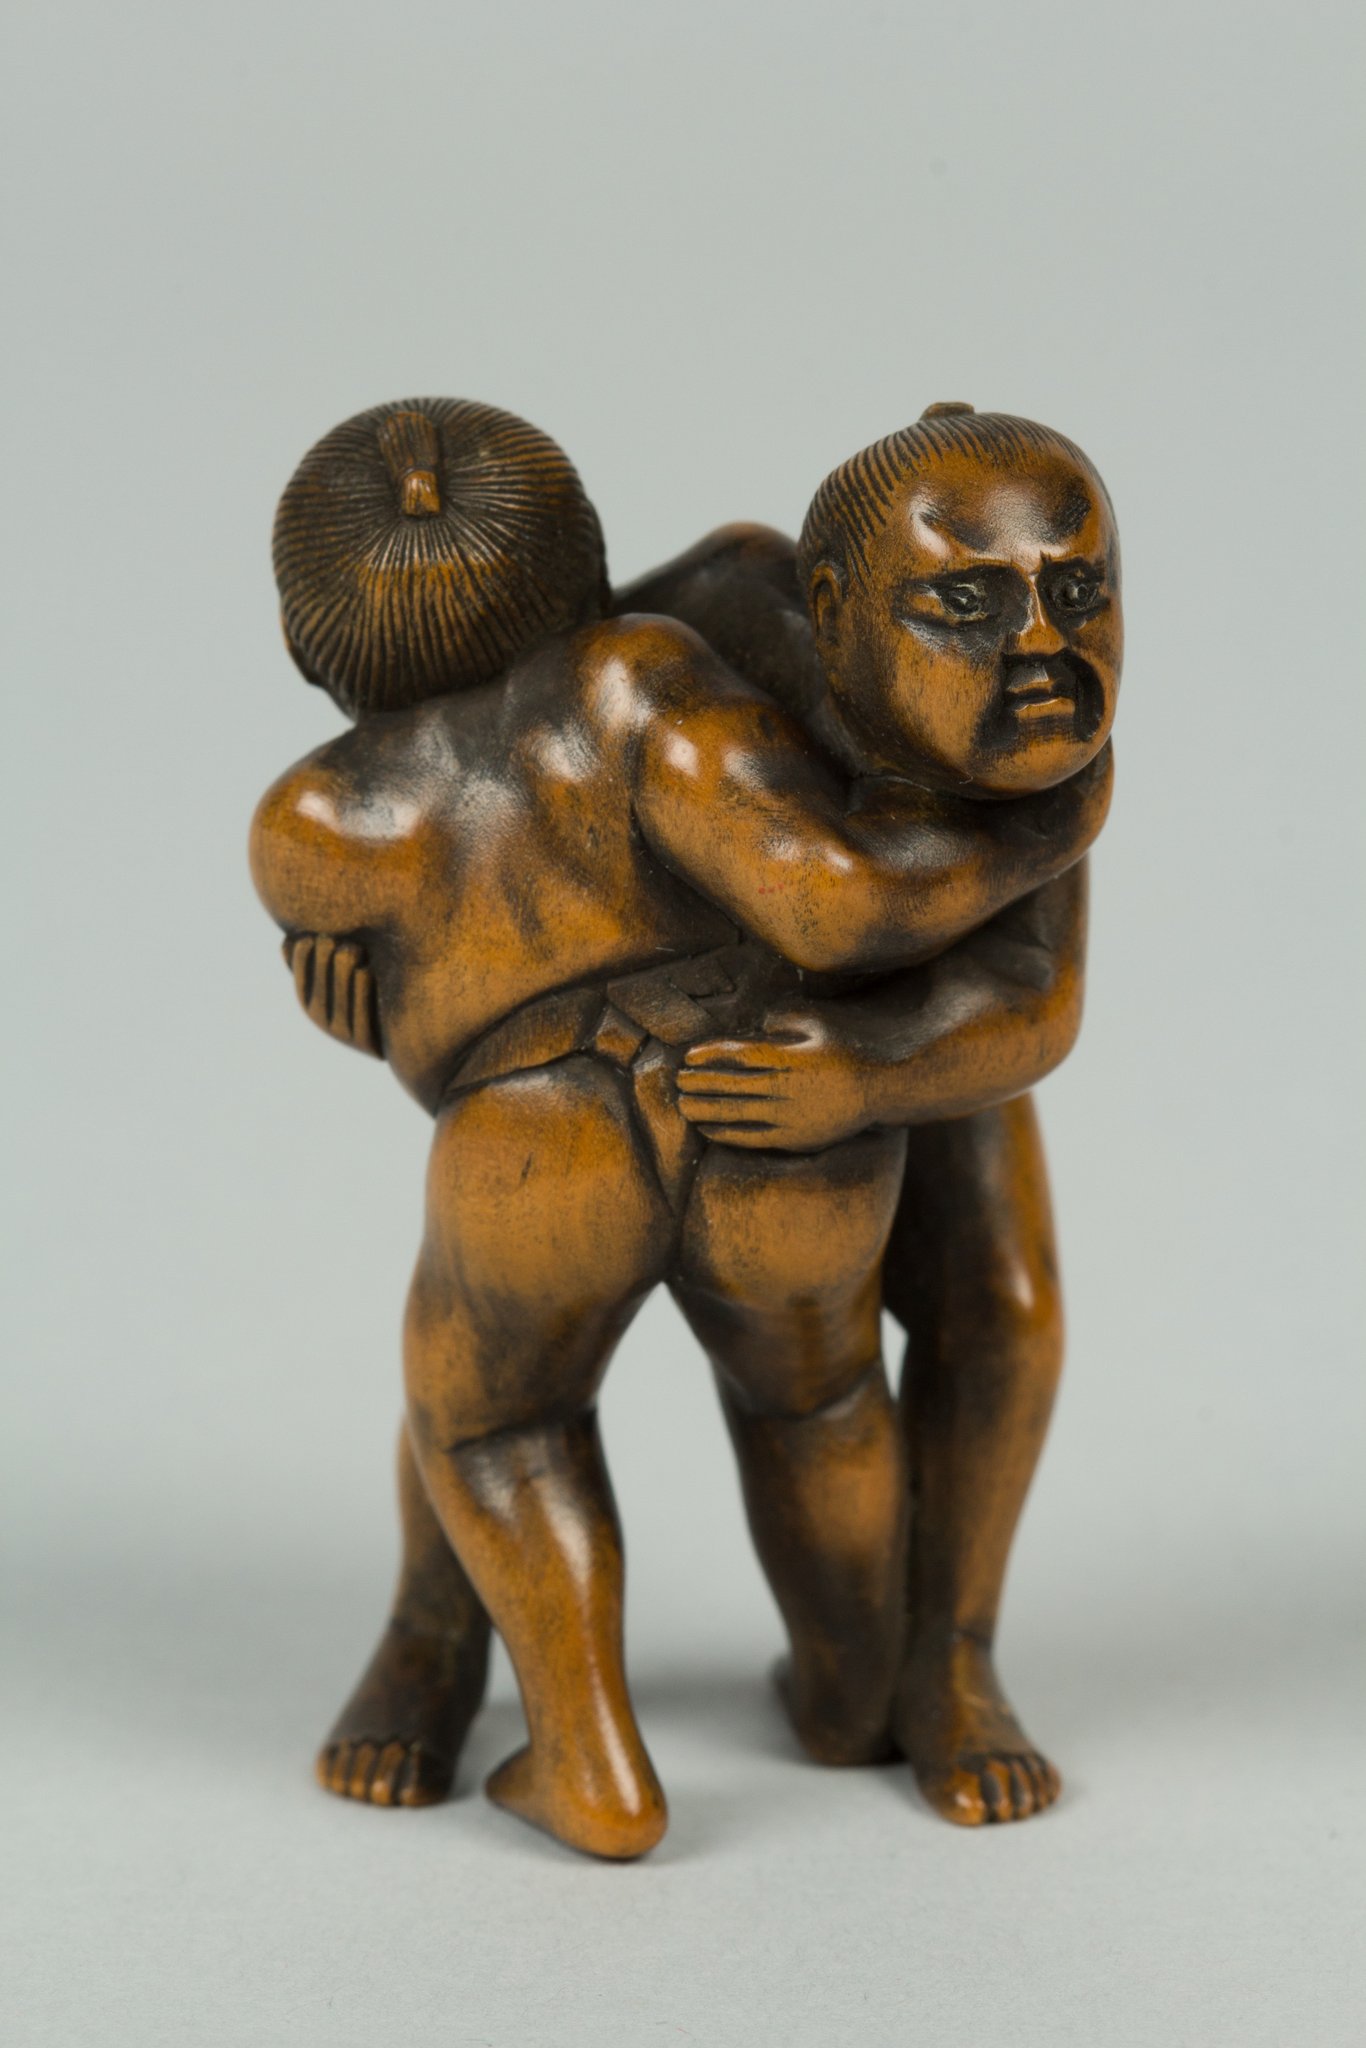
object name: netsuke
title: Netsuke of Two Men Wrestling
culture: japanese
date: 1701-1800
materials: wood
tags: men,wrestling